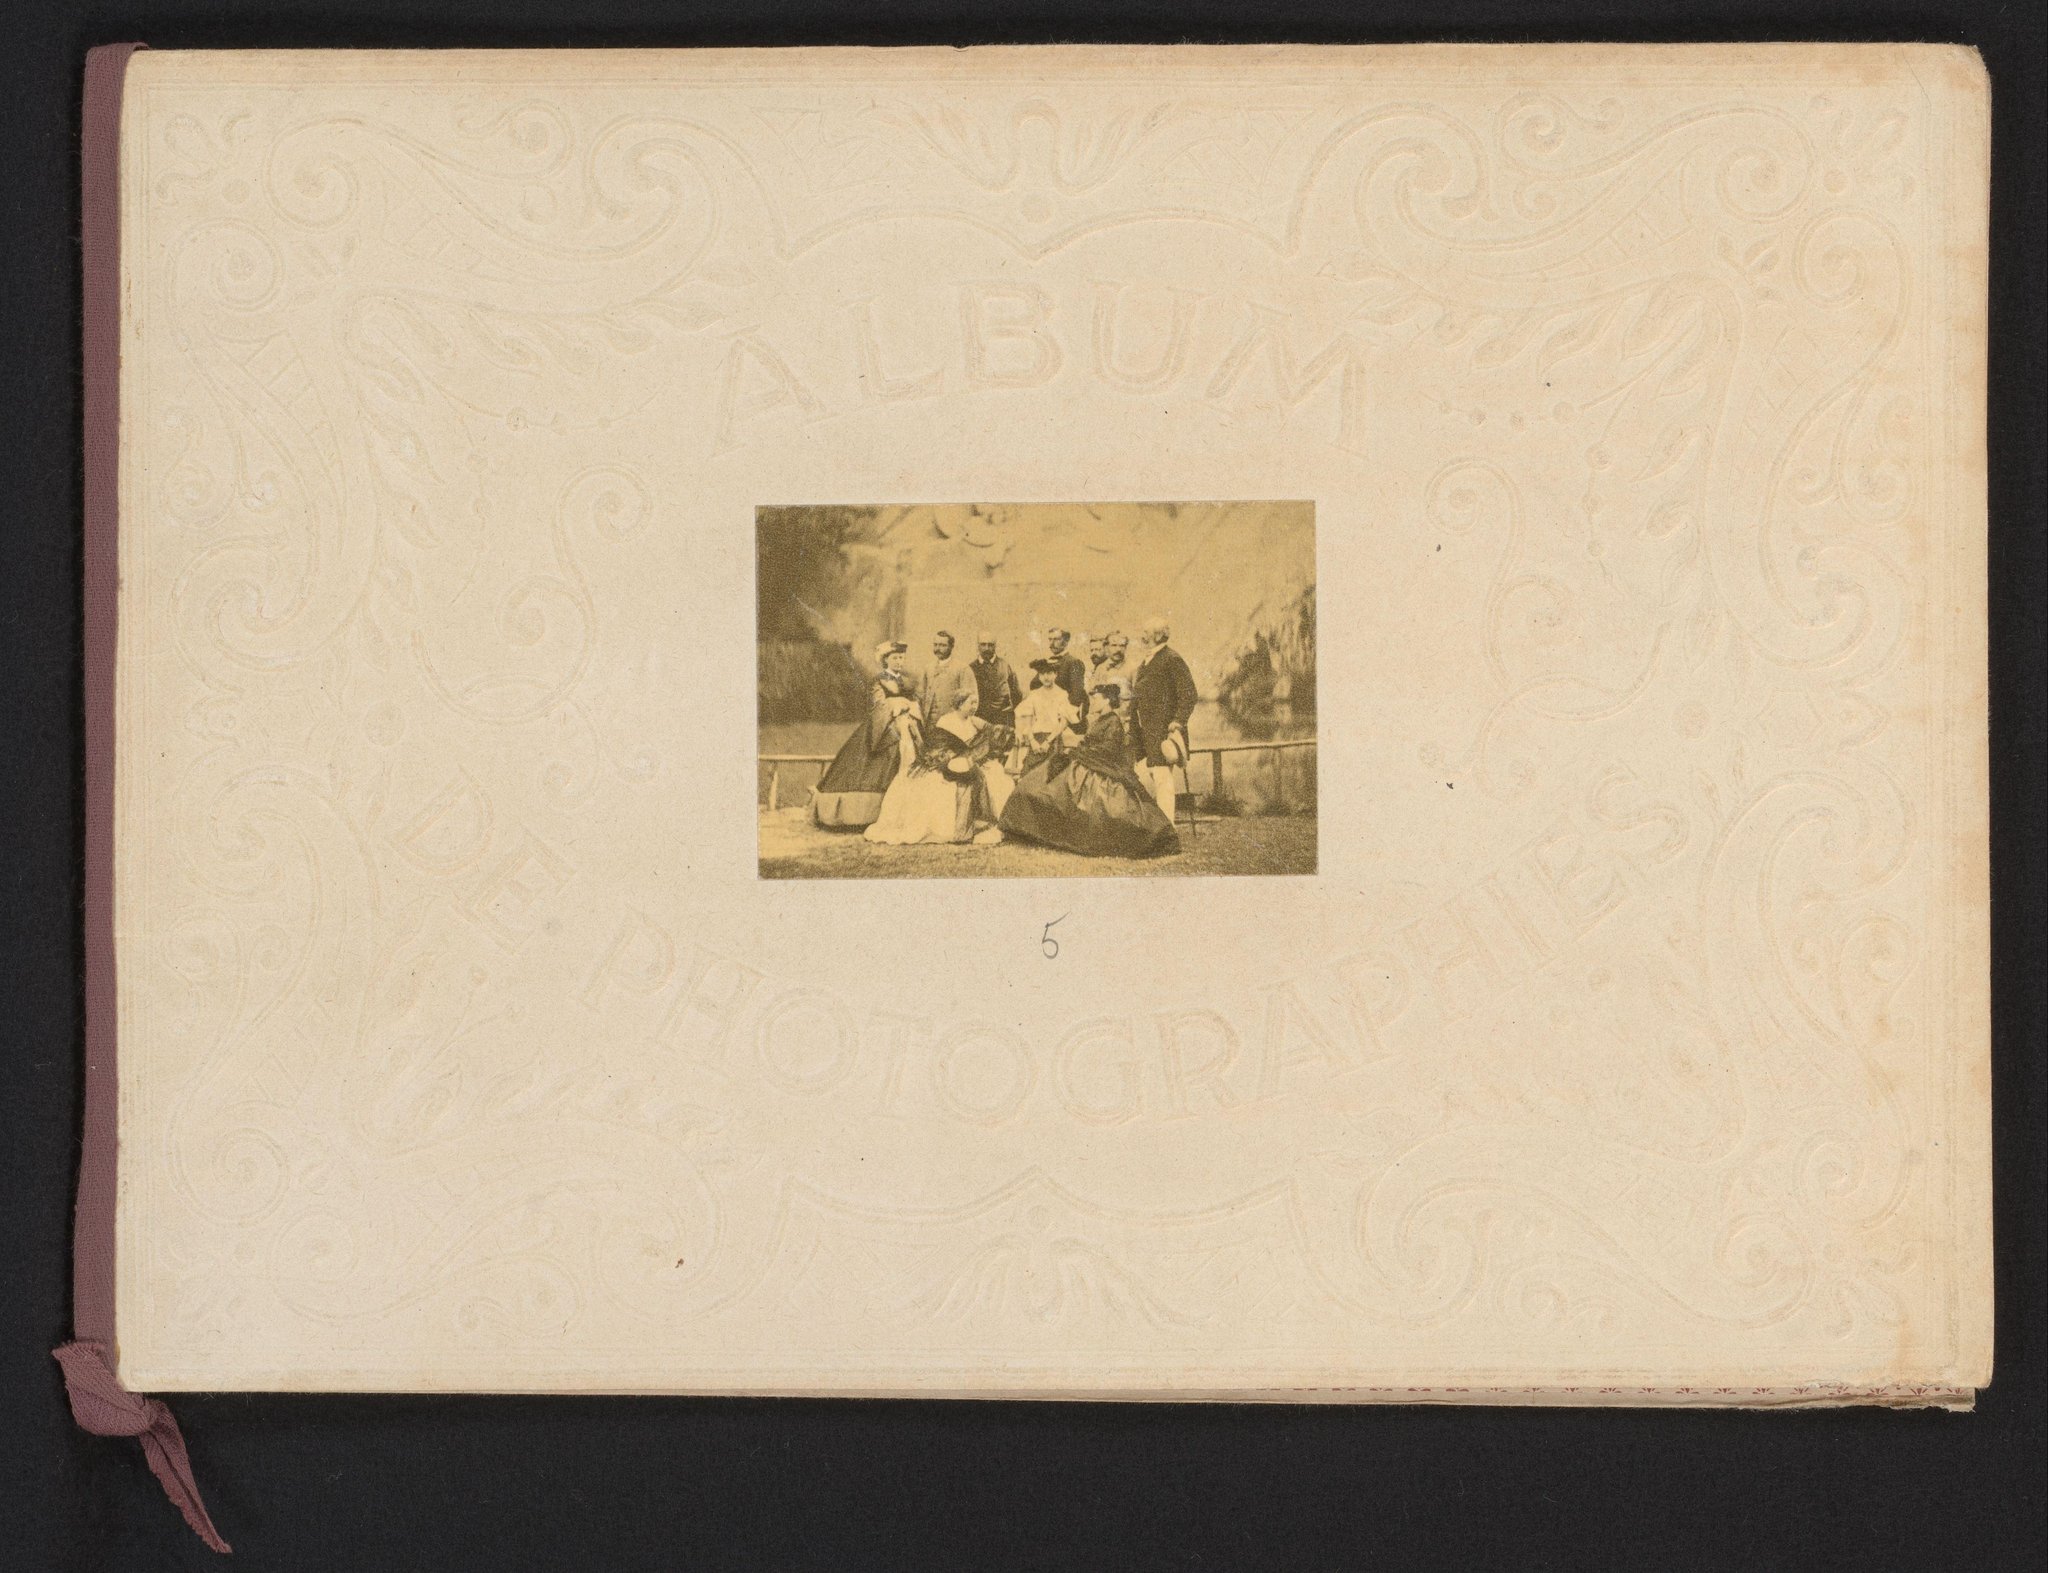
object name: photograph album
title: Dans l'intimité de personnages illustres 1865-1910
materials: cardboard, paper, photographic support, textile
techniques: lithograph, rotogravure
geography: paris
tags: paris, politician, pierre-antoine berryer, painter, rosa bonheur, fernand forest, lille, emile auguste carolus-duran, print maker, draughtsman, henry bonaventure monnier, jules chéret, victor hugo, pierre loti, sculptor, sarah bernhardt, pierre auguste renoir, frédéric auguste bartholdi, alphonse daudet, octave mirbeau, portrait of actor, actress, writer, poet, author, science and technology (+ portrait of scholar, scientist), artist (in general), france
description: Plakboek met 32 portretten van bekende Franse wetenschappers, kunstenaars, auteurs, theatermakers, politici, regeringsleiders en geestelijken verdeeld over 12 bladen, samengesteld door J.M. Dufrénoy in reactie op zijn grootvader, Pierre-Marie Lizerolles, die hiermee begonnen was. Deel 5. Op het voorplat een rotogravure van een groepsportret.